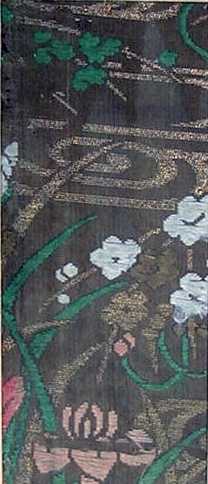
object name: piece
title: Textile with Partial Pattern of Irises and Water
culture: japanese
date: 1615-1868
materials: metal thread, silk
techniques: brocade, patterning, weave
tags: flowers